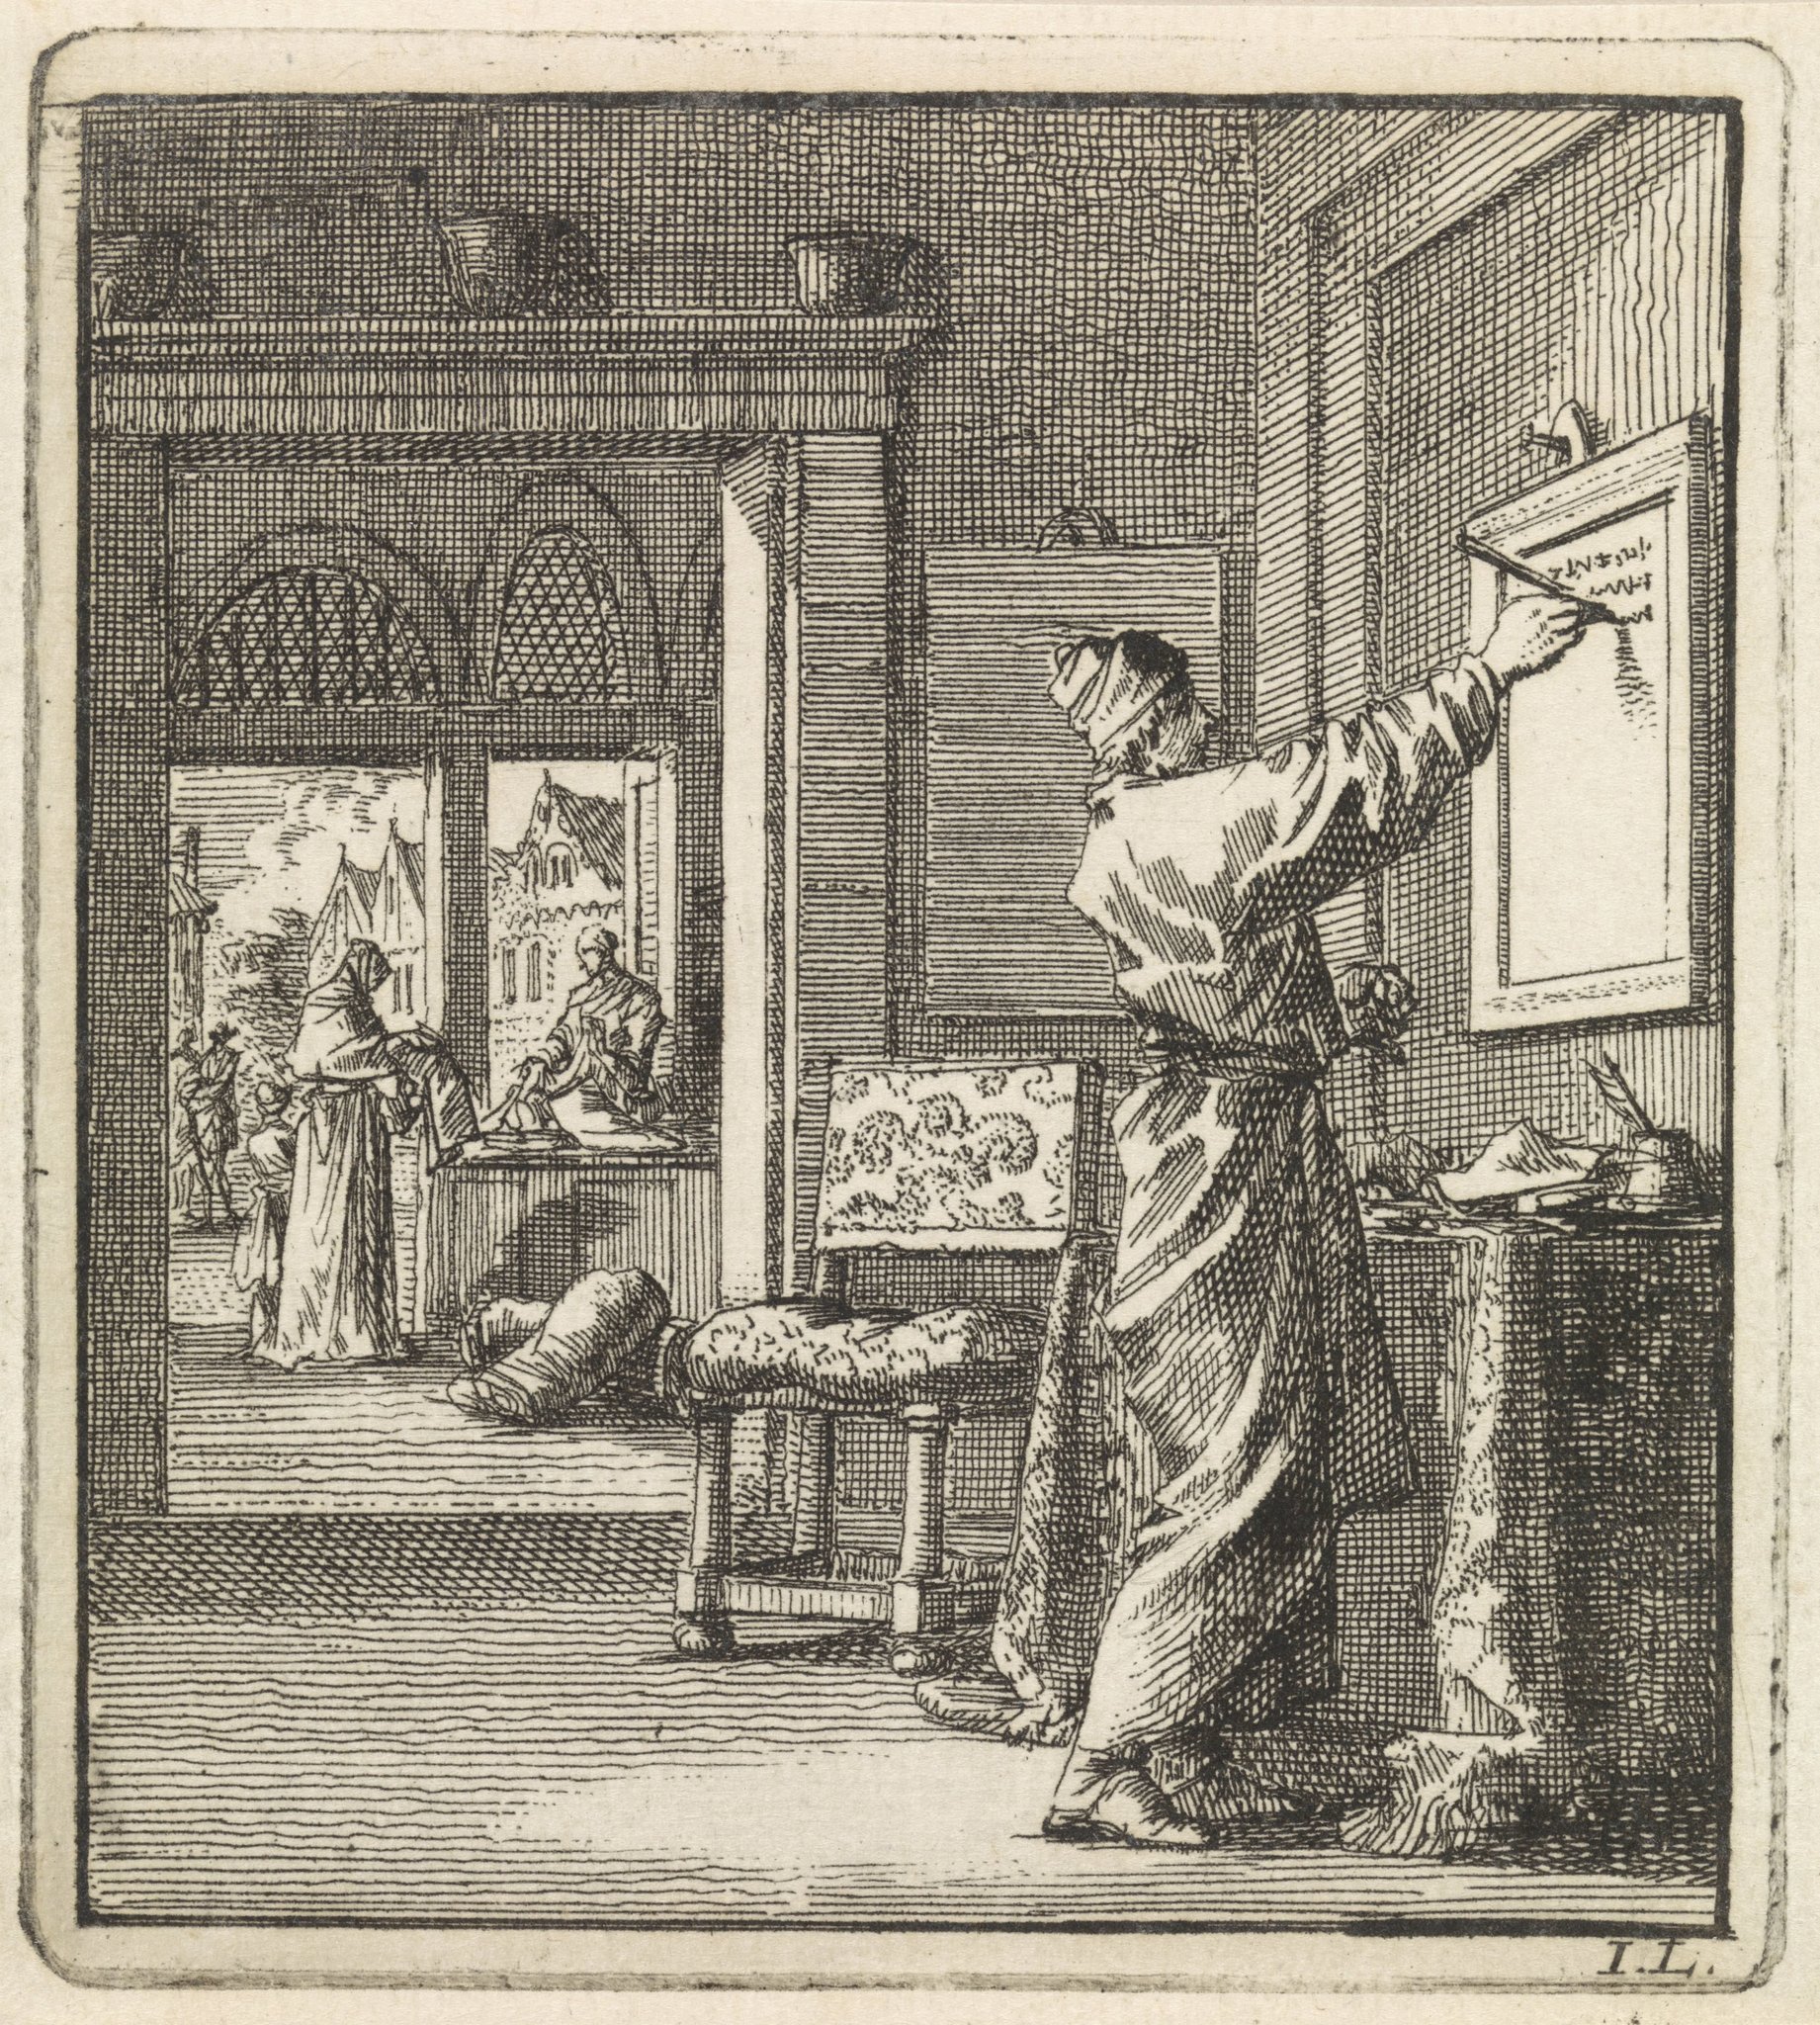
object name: book illustration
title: De Schryf-ley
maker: jan luyken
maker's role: draughtsman, print maker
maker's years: 1649-1712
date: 1711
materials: paper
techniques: etching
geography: amsterdam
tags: handwriting, writing as activity, slate (writing material)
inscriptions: collector's mark: Lugt 2228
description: Illustratie voor: Luyken, Jan. Het leerzaam huisraad, vertoond in vyftig konstige figuuren, met godlyke spreuken en stichtelyke verzen: Pieter Arentsz. II (wed.) en Cornelis van der Sys, 1711, p. 172.